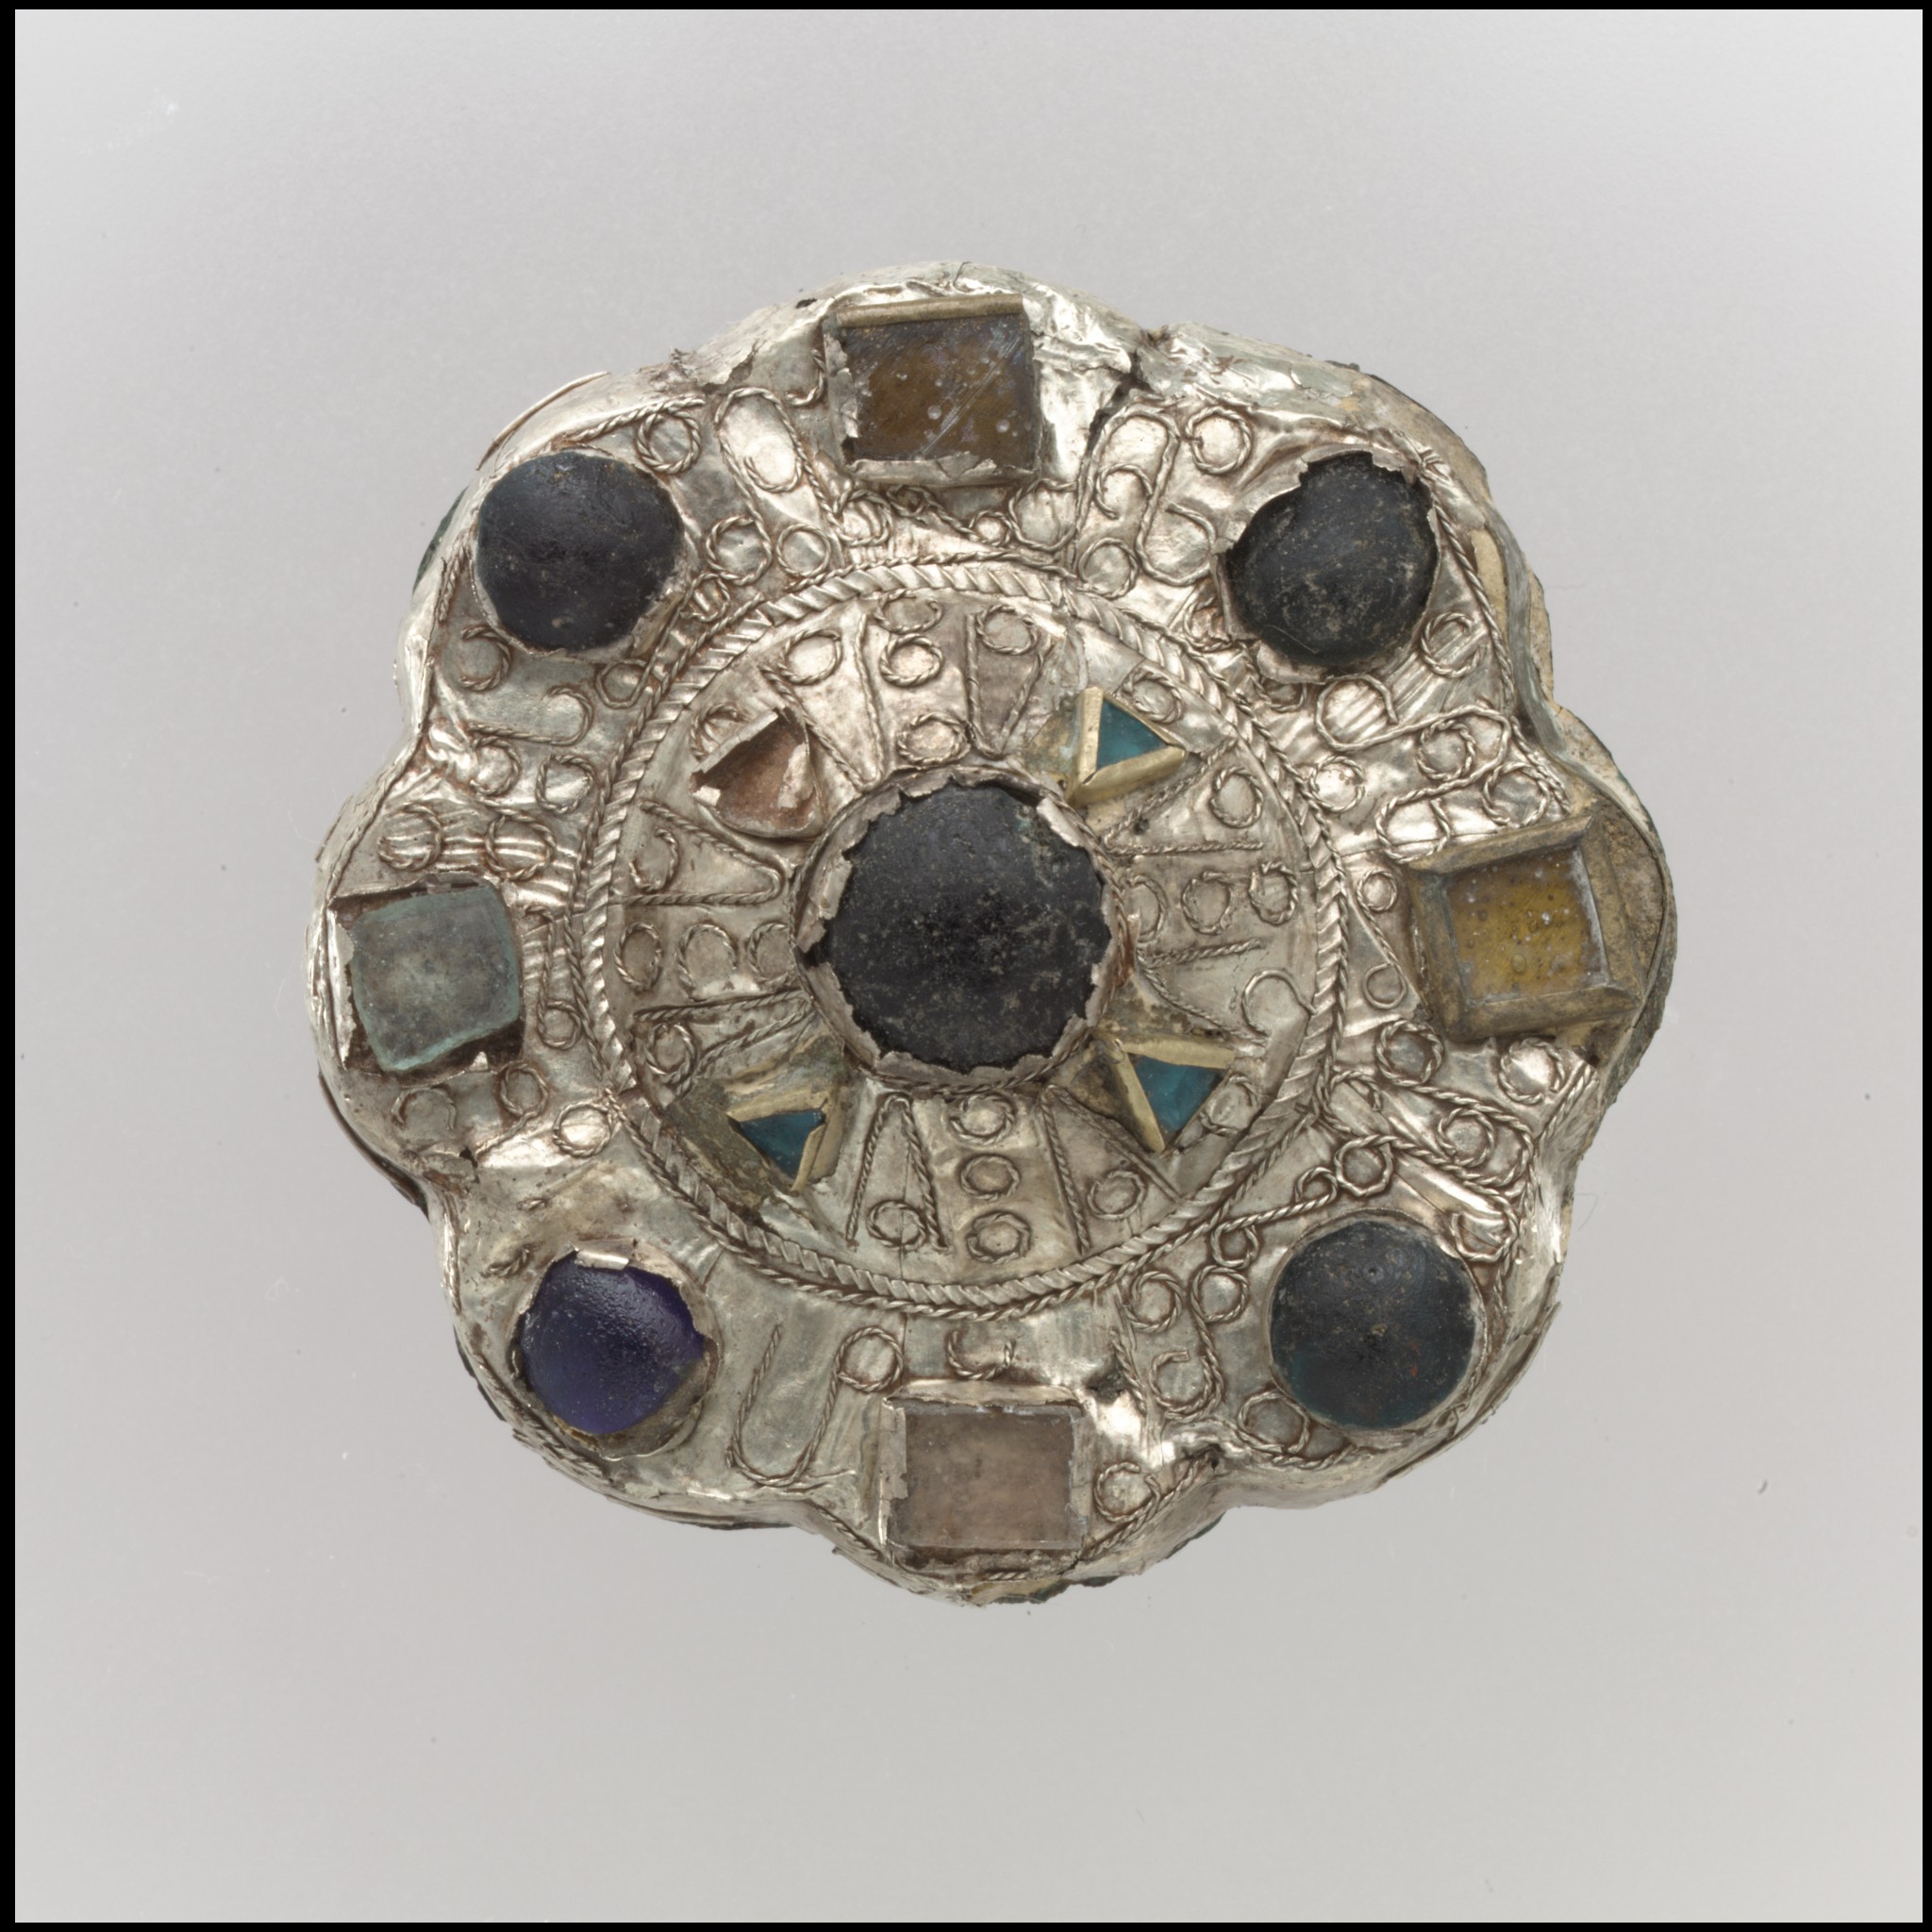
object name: brooch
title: Disk Brooch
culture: frankish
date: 601-700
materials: glass, silver